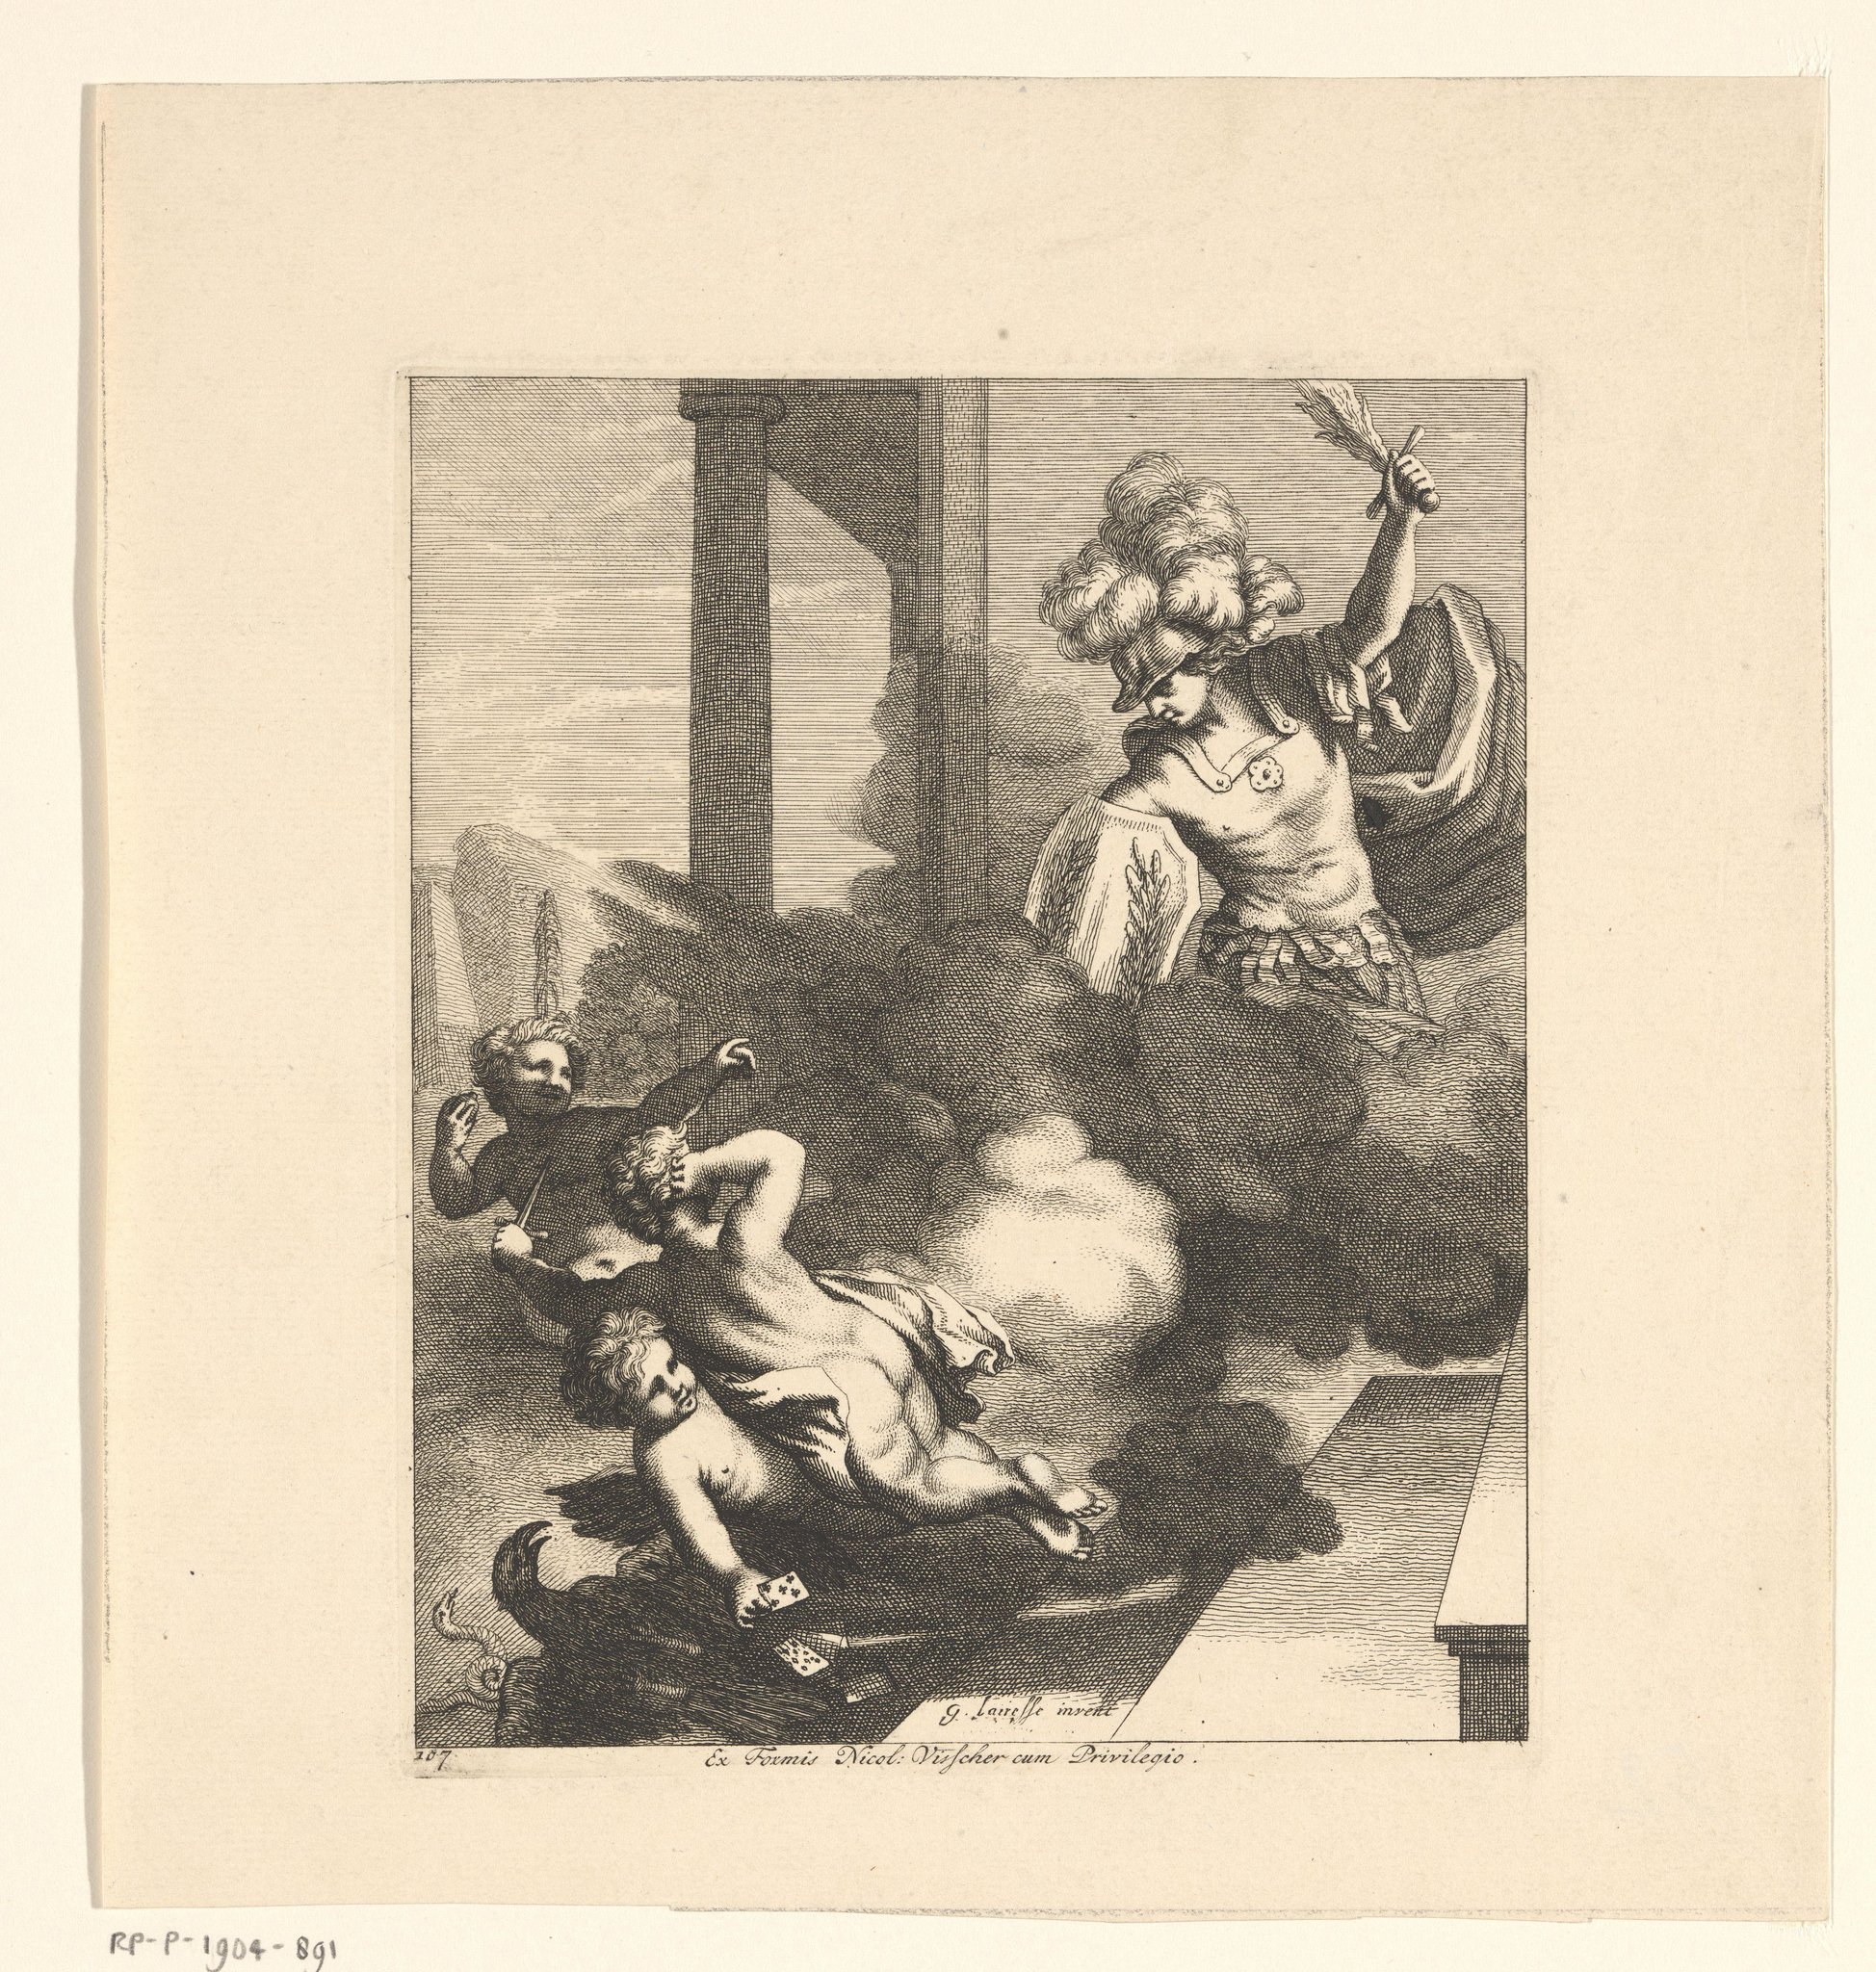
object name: print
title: Deugd verdrijft ondeugden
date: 1679-1702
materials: paper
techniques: etching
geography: low countries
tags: snakes, predatory birds: eagle, strife between virtues and vices, psychomachy, playing-cards, cupids: 'amores', 'amoretti', 'putti'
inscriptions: collector's mark: Lugt 2228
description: Rechts staat de personificatie van de Deugd in de gedaante van een man in wapenrusting voor een klassiek gebouw. In zijn rechterhand heeft hij een schild met een lauwerkrans en in zijn opgeheven rechterhand een vlammend zwaard. Links duiken drie putti voor hem weg. De bovenste putto heeft mogelijk een citroen vast als symbool van zure liefde en valse vriendschap. De dolk van de middelste putto symboliseert toorn en de onderste putto laat speelkaarten, symbolen van twist en luiheid, vallen. Onder hen een slang, het kwaad, en een adelaar als symbool van hoogmoed. Linksonder: 107.